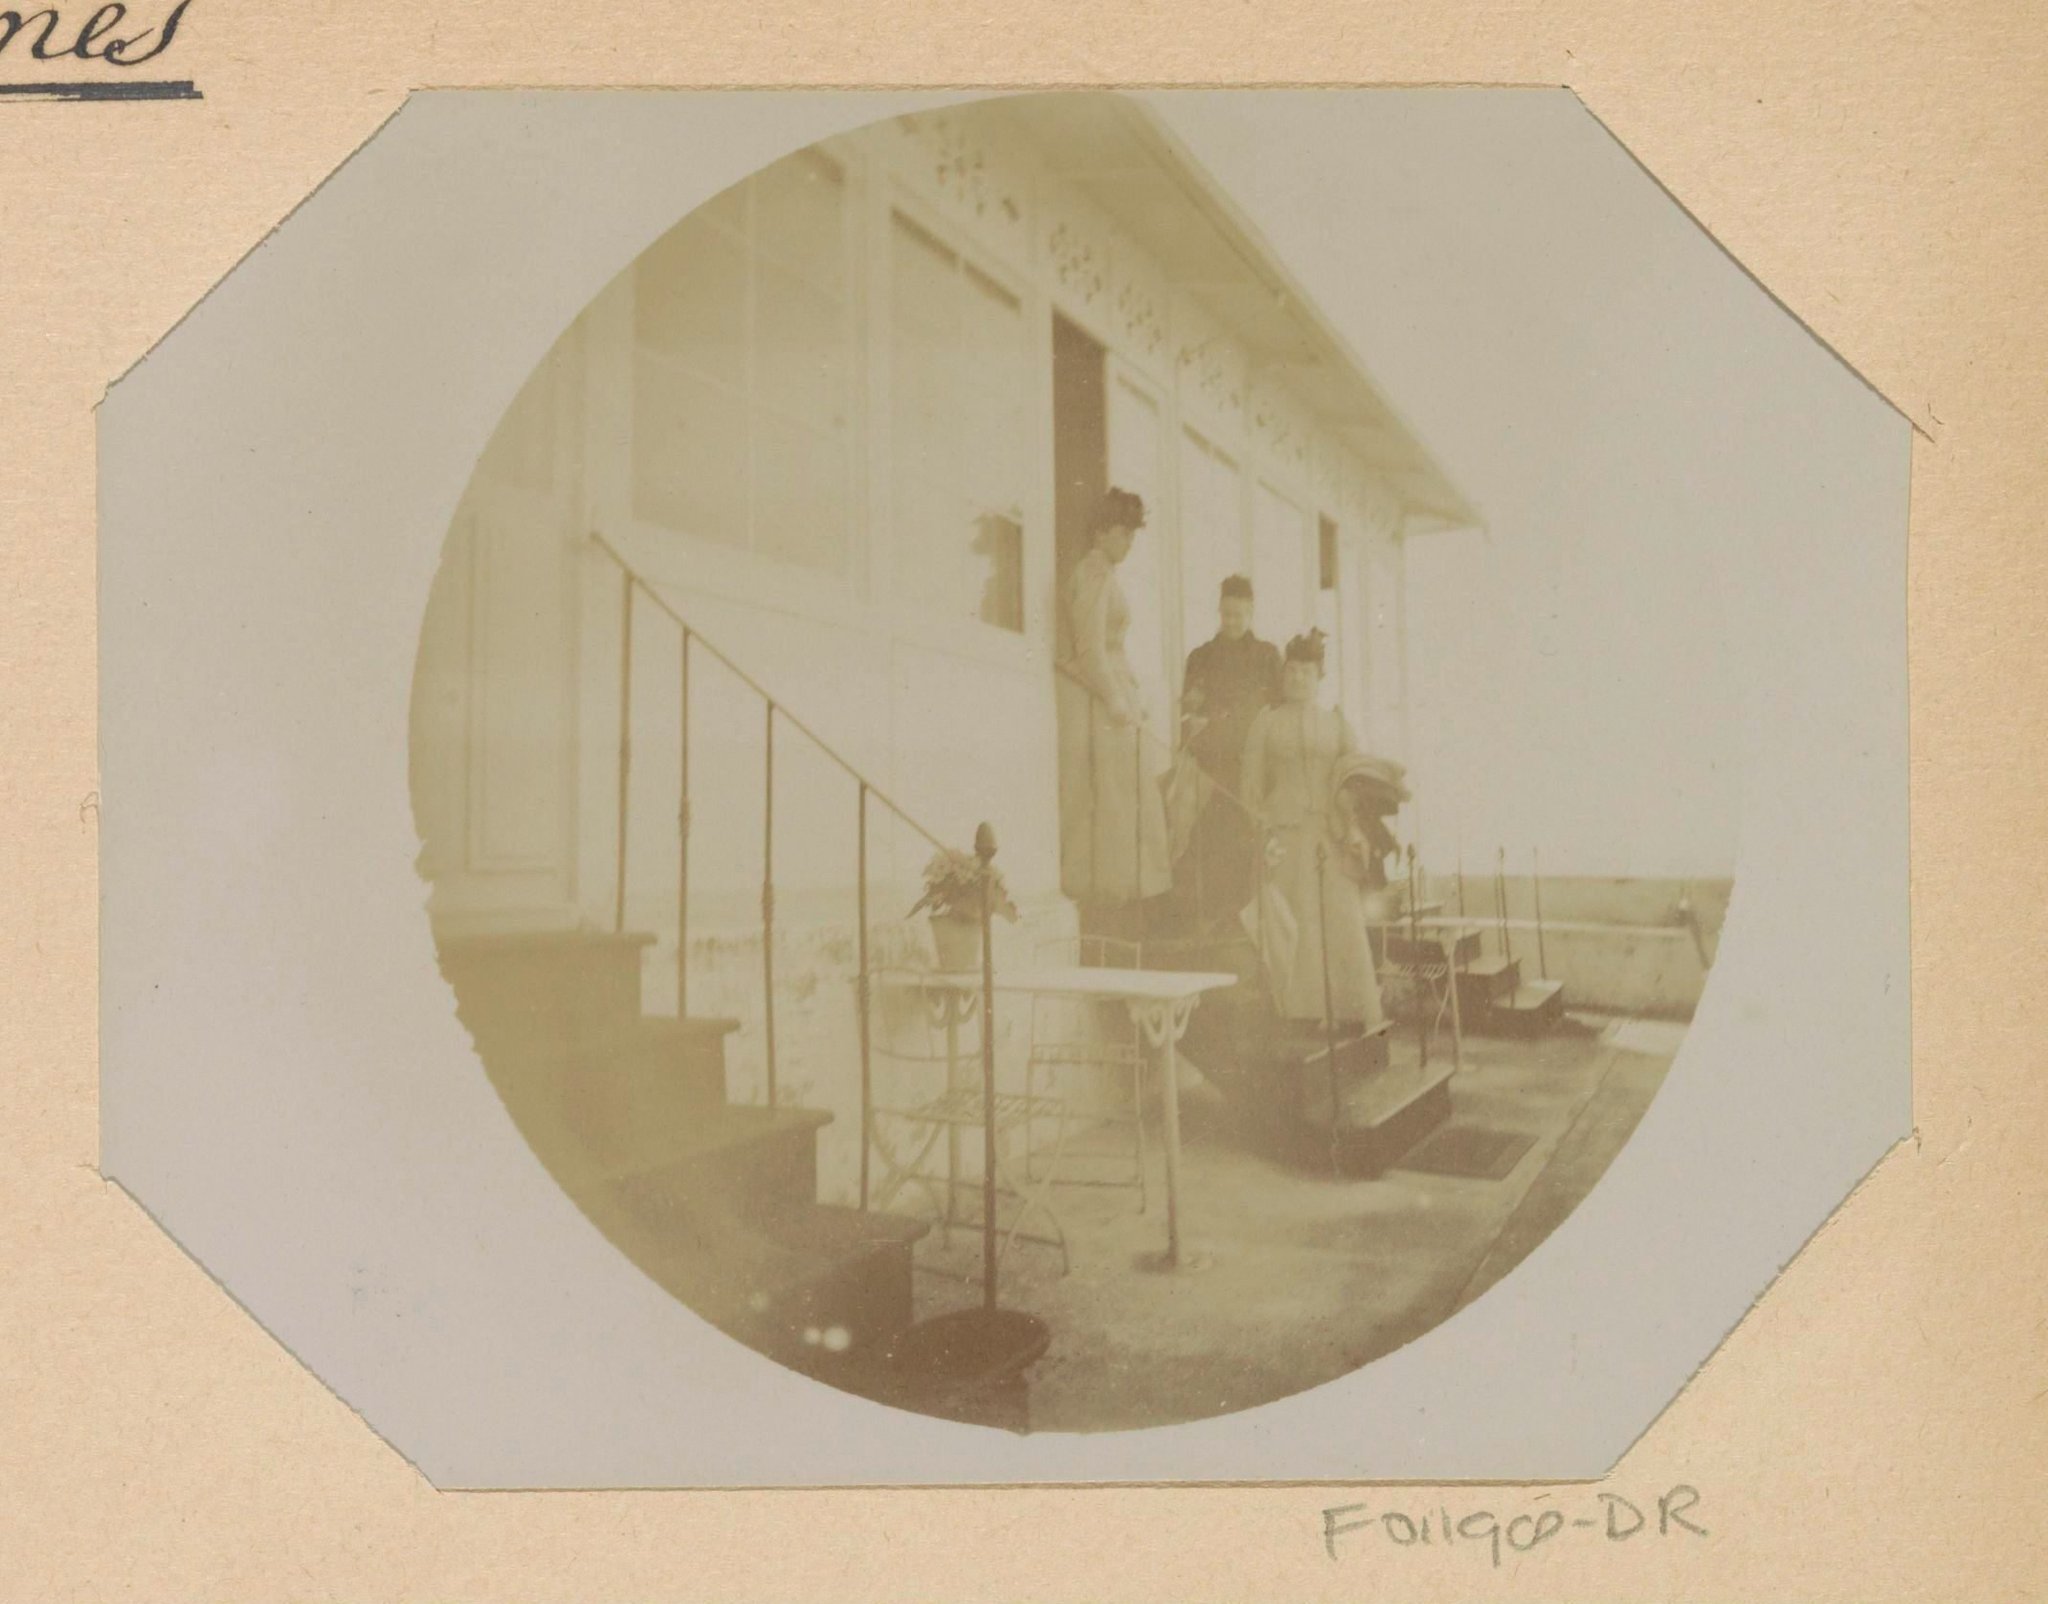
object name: album leaf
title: Drie vrouwen op een buitentrap, in het midden Lucia Wilhelmina Piek-Jolles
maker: johanna margaretha piek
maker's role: fotograaf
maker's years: 1870-1947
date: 1889-1893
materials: paper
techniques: gelatin silver print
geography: cannes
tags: amsterdam, adult woman